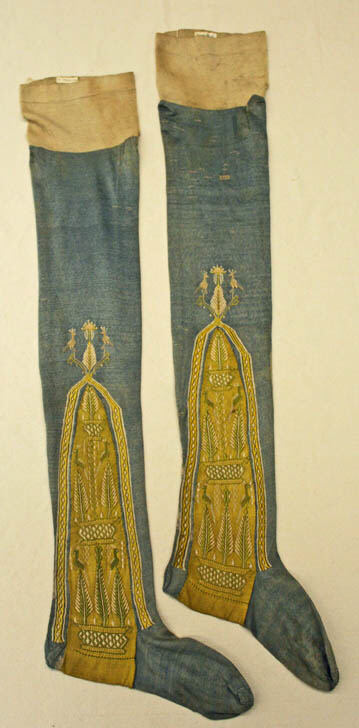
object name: stocking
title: Stockings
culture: french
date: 1801-1833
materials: silk